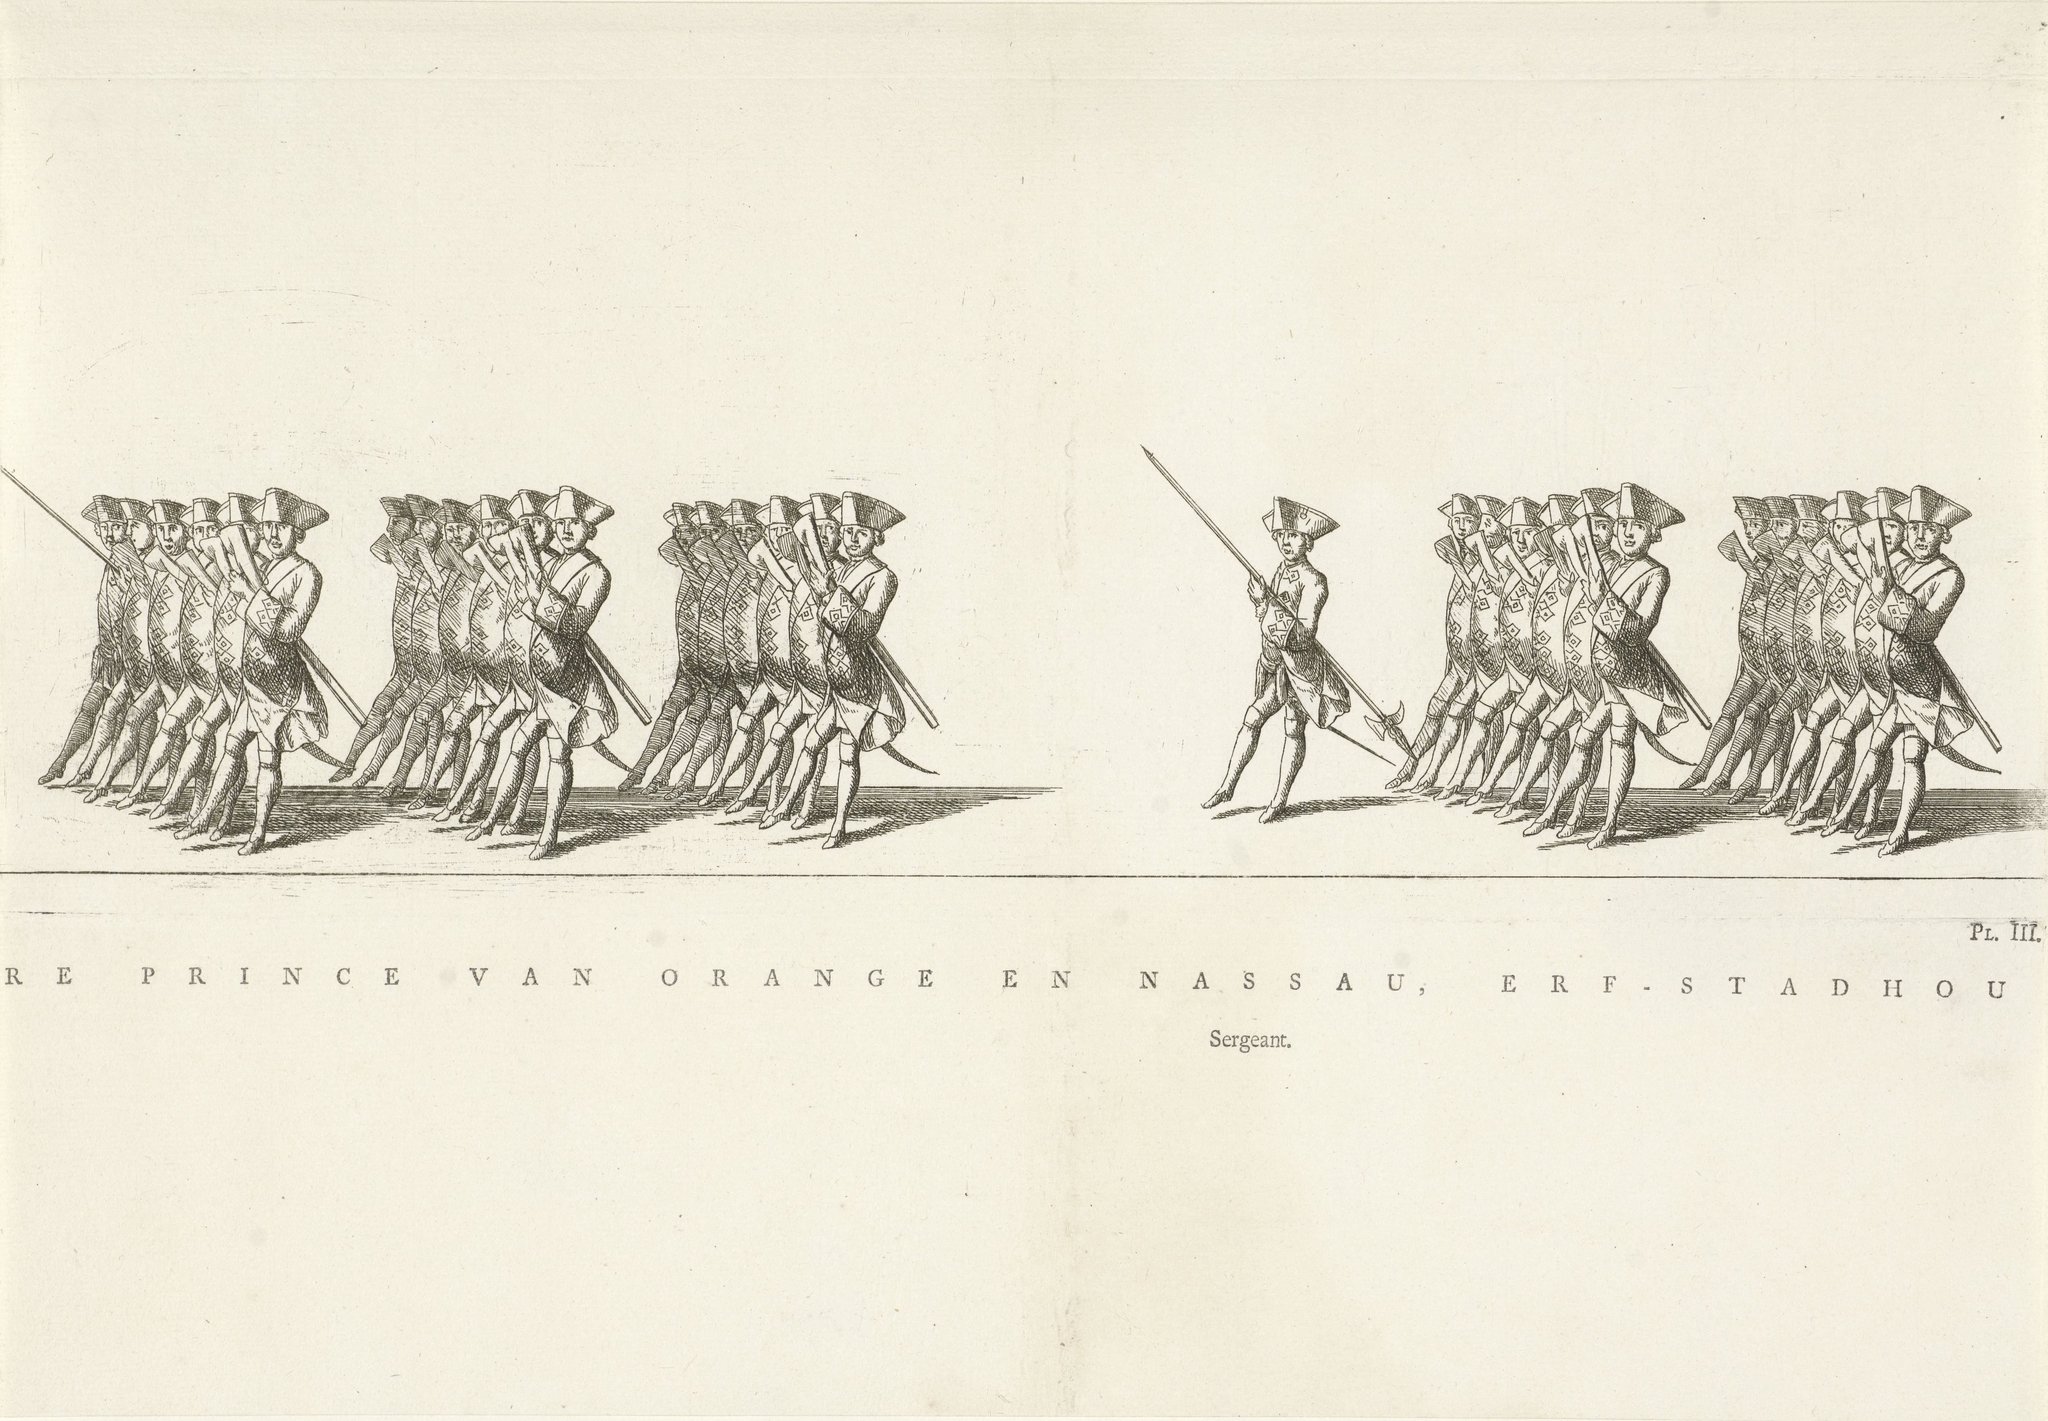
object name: print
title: Friese Garde du Corps in de begrafenisstoet van prinses Maria Louise, 1765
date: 1765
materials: paper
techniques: etching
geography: leeuwarden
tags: cortege, funeral procession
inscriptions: collector's mark: Lugt 2228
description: Soldaten van de Friese Garde du Corps. Gemerkt rechtsonder: Pl. III. Op het blad onder de plaat een deel van de titel en de vermelding van de sergeant. Onderdeel van de serie platen van de begrafenis van prinses Maria Louise te Leeuwarden op 13 juni 1765.